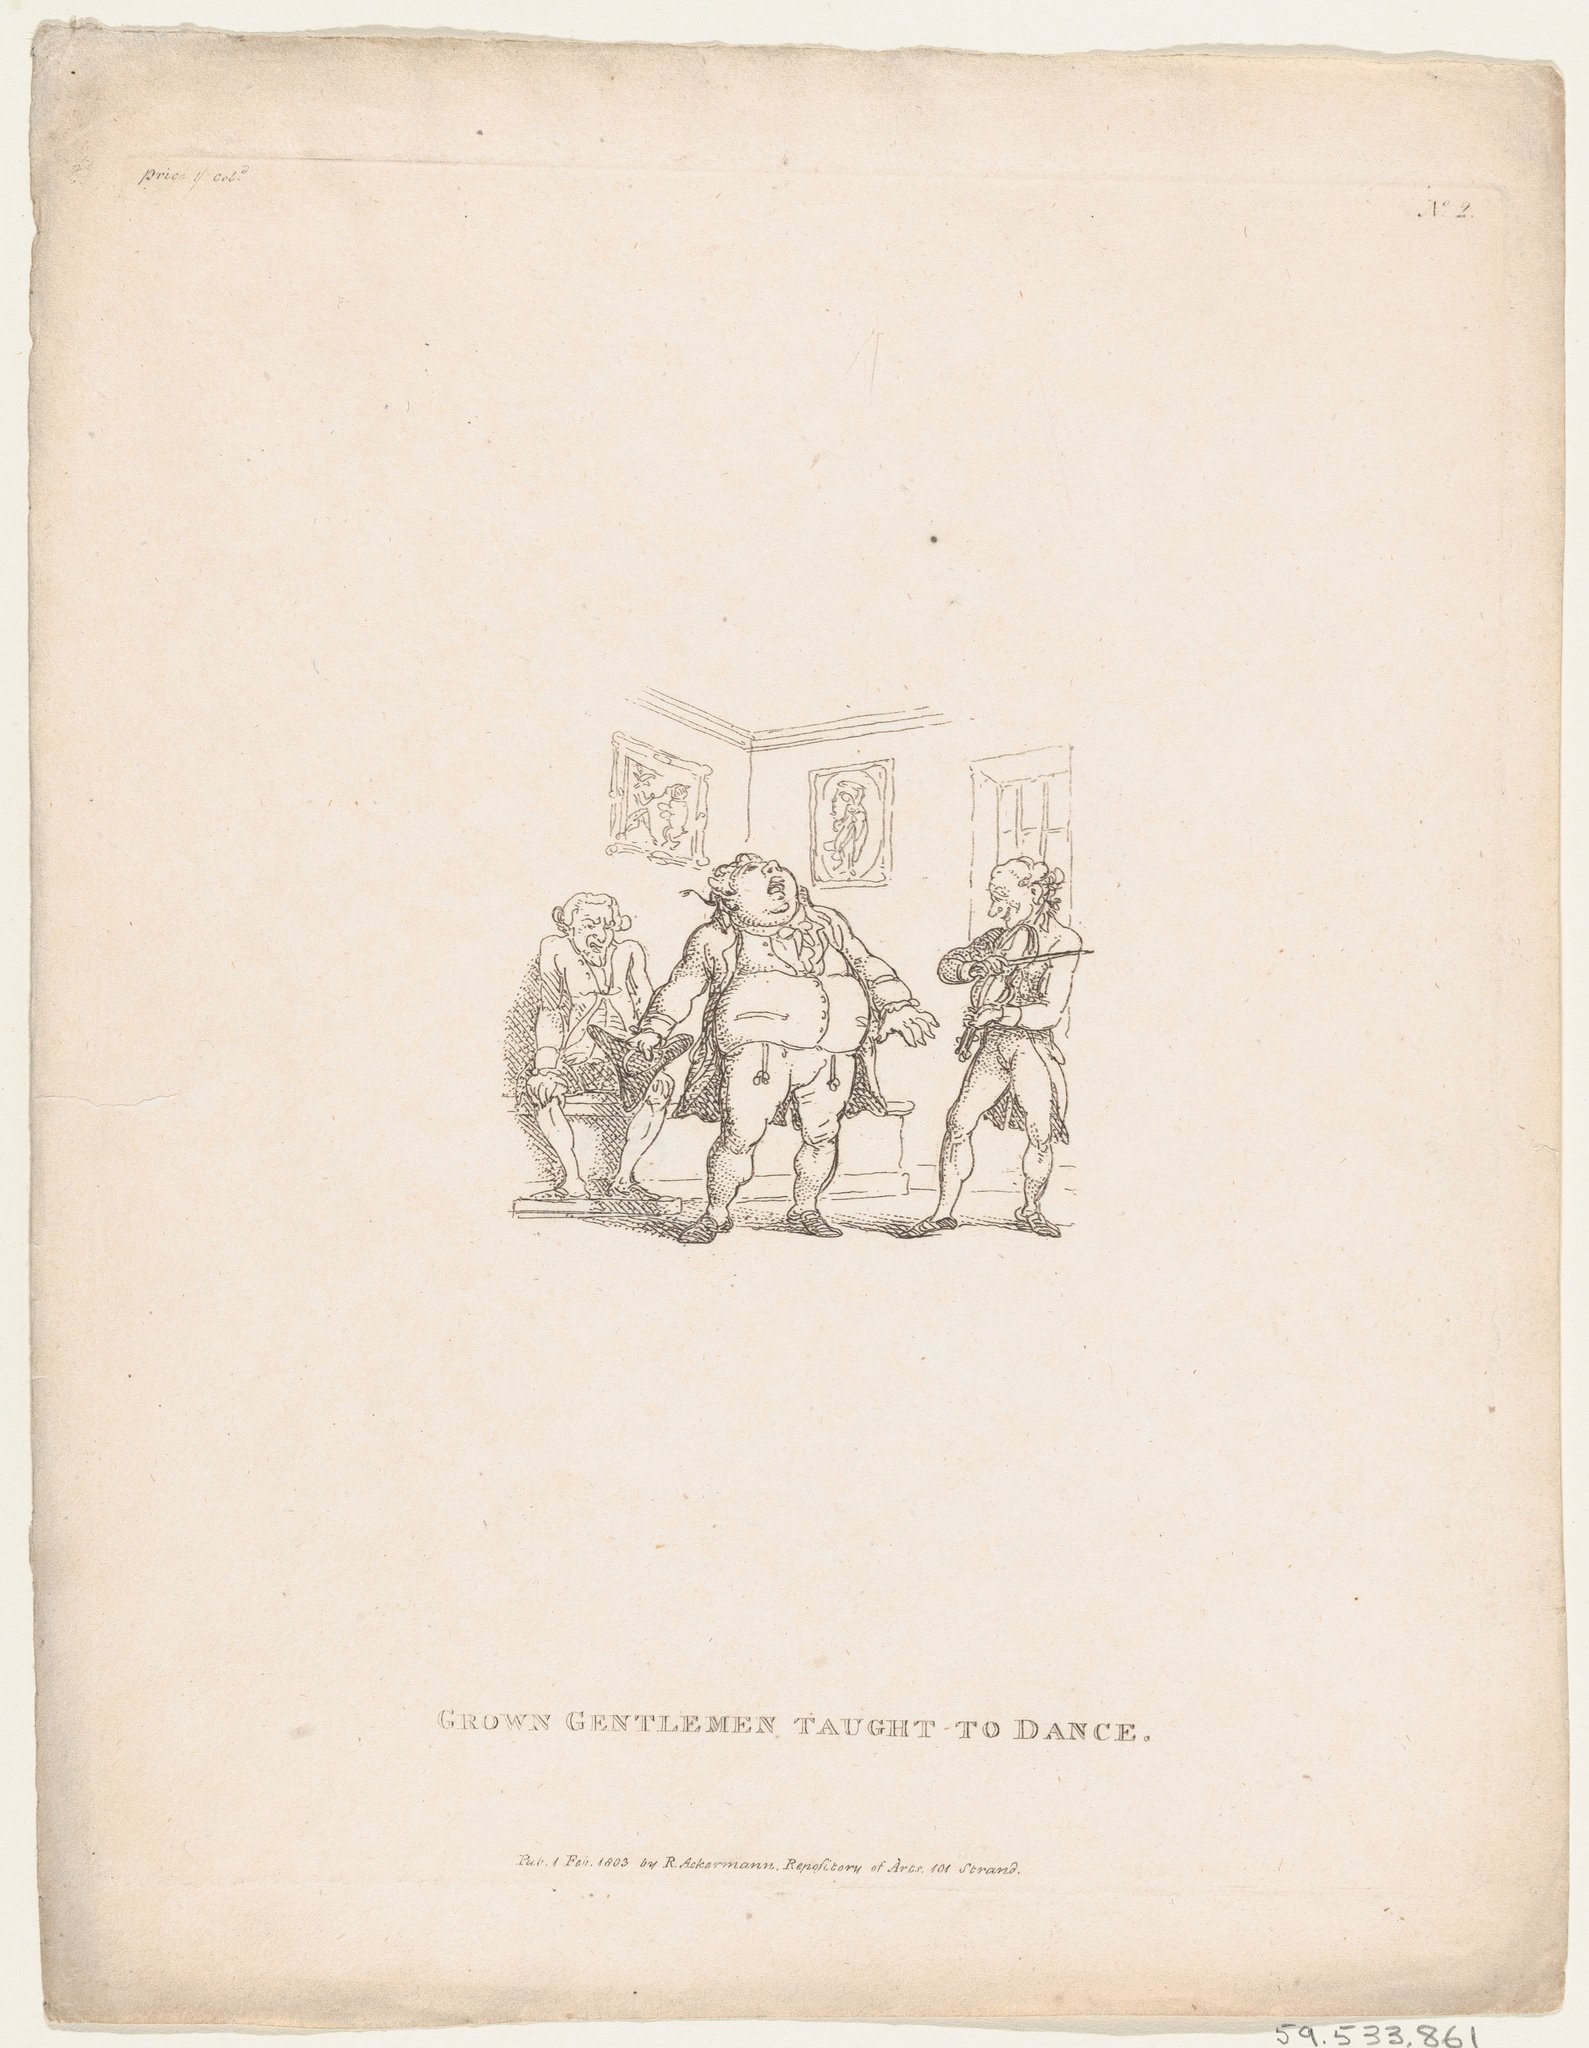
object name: print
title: Grown Gentlemen Taught to Dance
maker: henry william bunbury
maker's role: artist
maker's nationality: british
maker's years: 1750-1811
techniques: etching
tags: satire,men,musicians